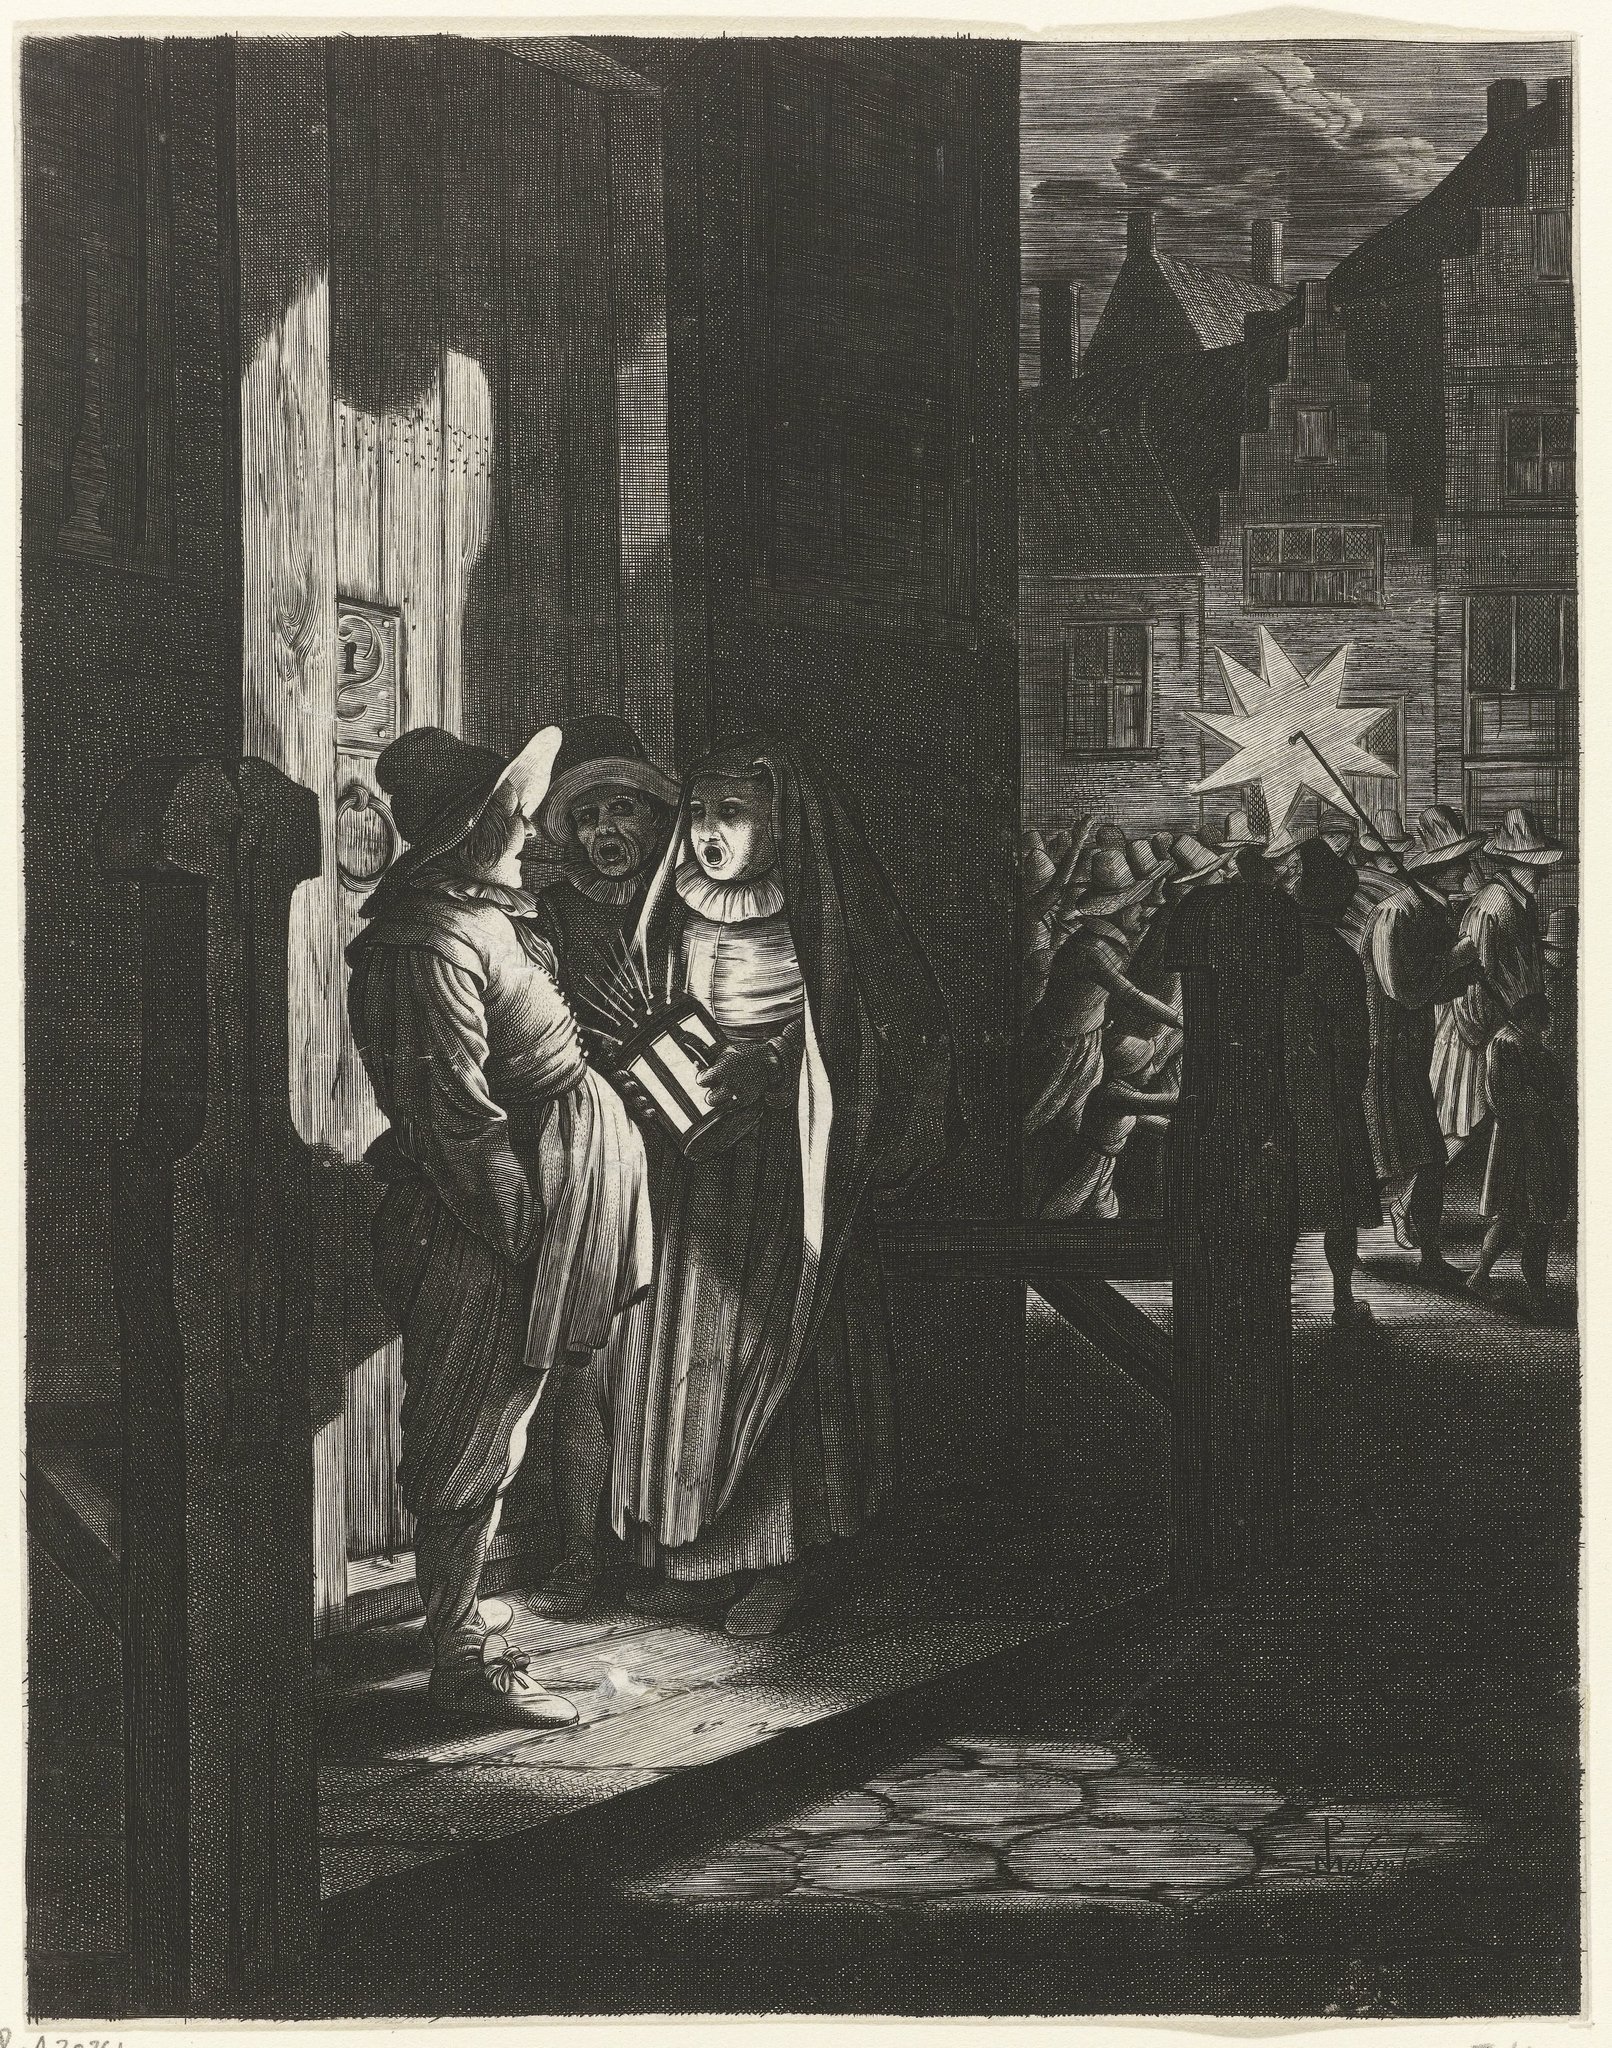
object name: print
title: Driekoningen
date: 1603-1641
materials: paper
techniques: engraving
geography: northern netherlands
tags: twelfth night, usually falling on the eve of january 6, lantern, night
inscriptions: collector's mark: Lugt 964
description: Drie figuren met een lantaarn bij een deur, bij nacht. Daarachter een dorpsstraat met een optocht van mensen, van wie een met een driekoningenster over de schouder.